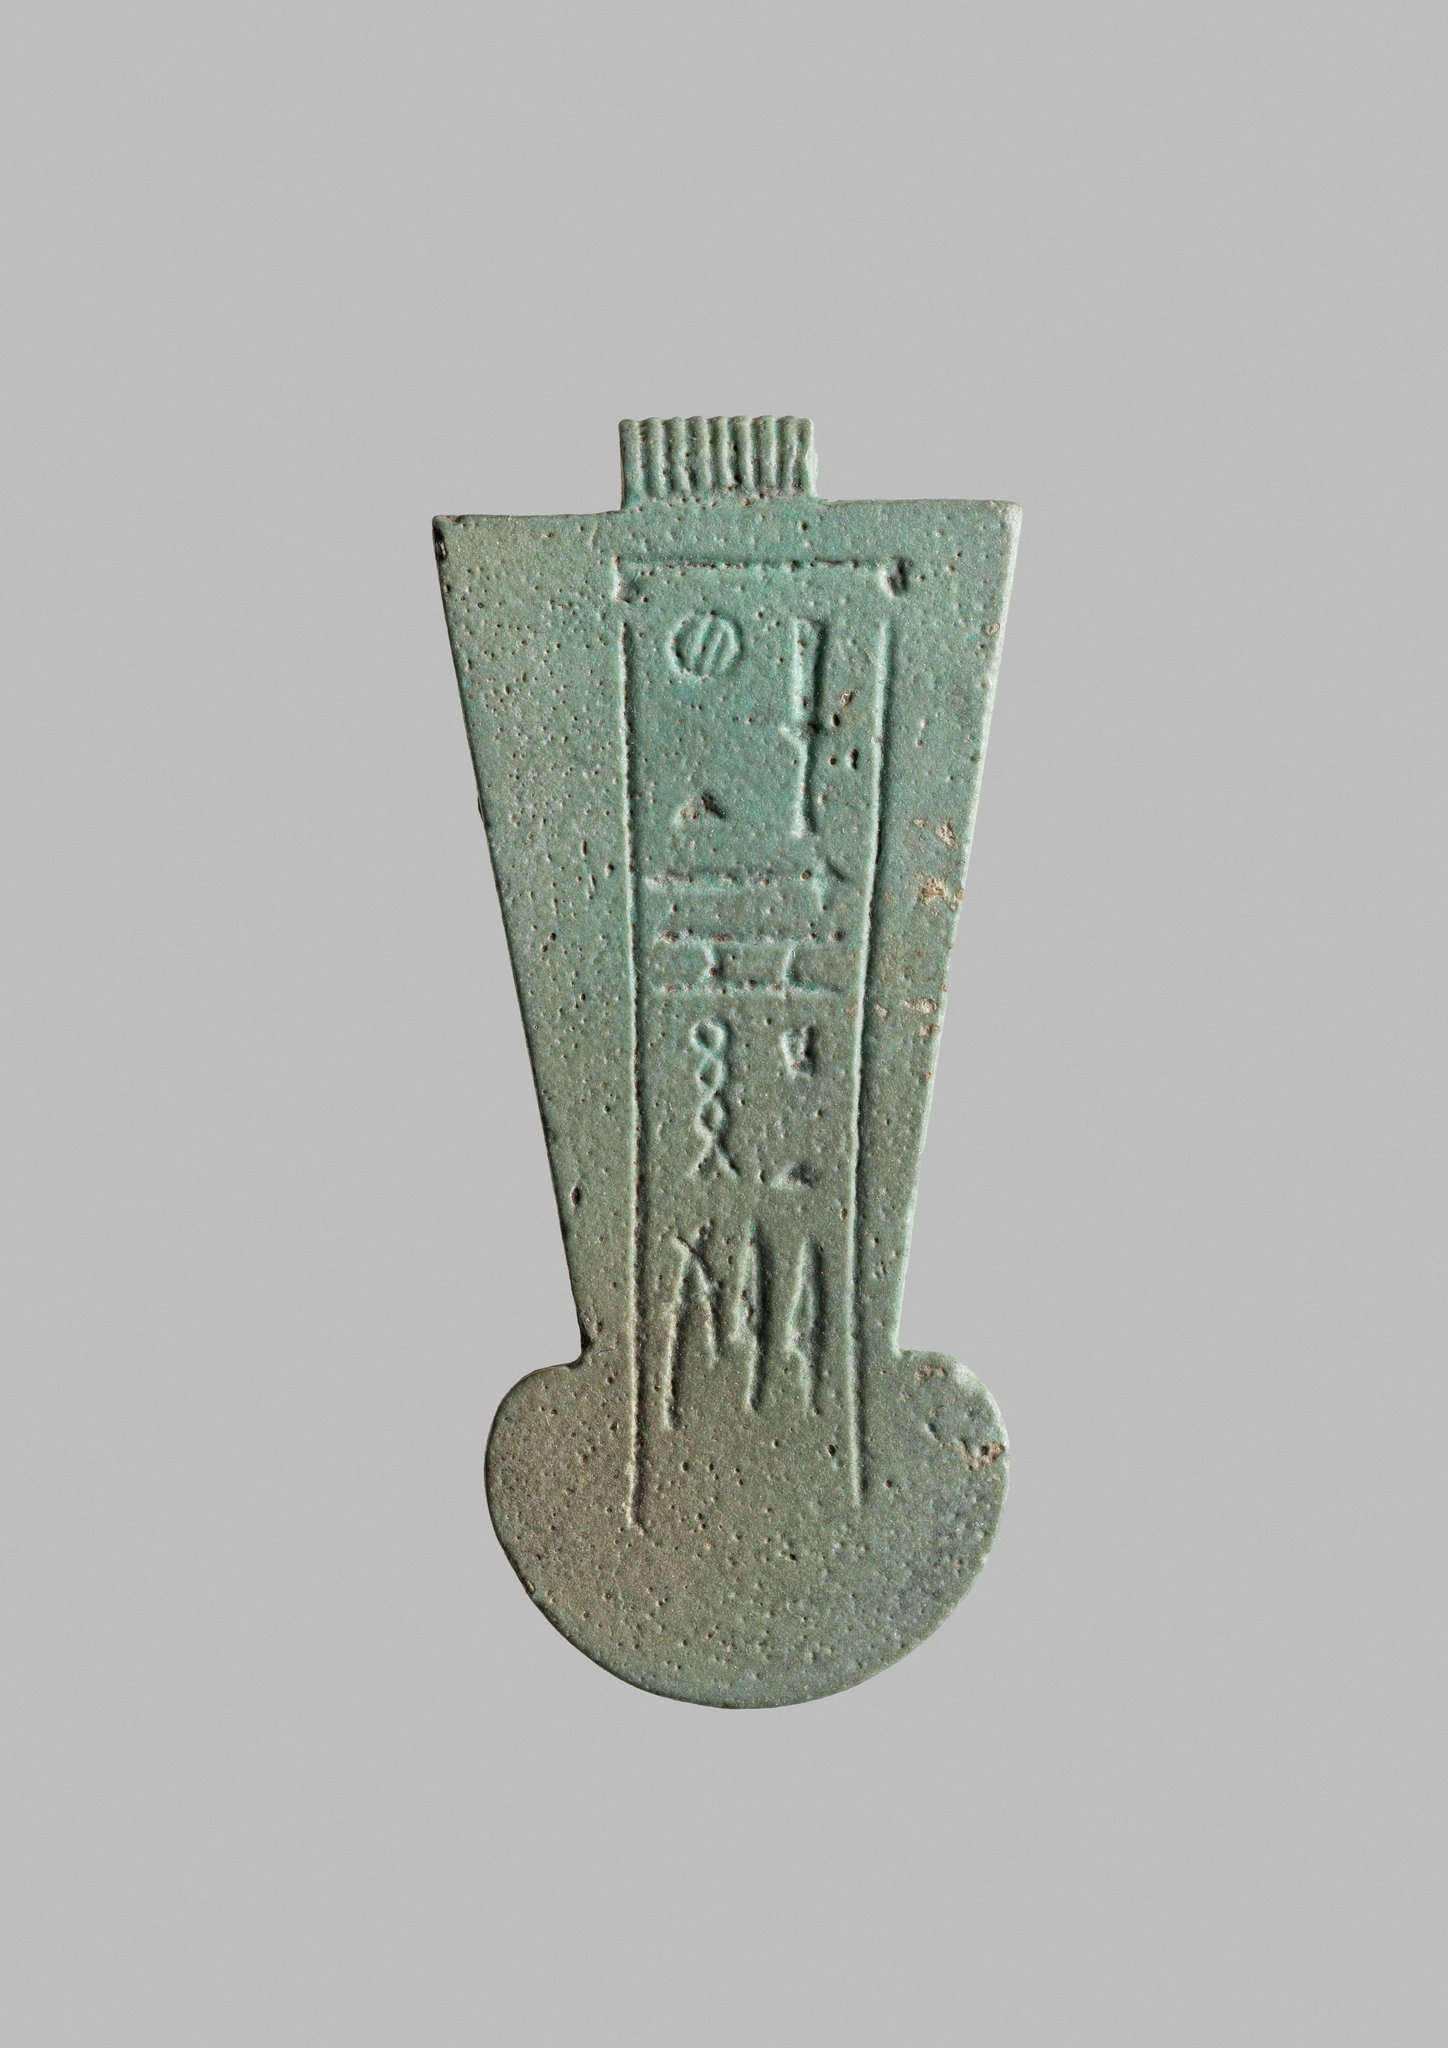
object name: menat counterpoise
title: Menat Counterpoise inscribed beloved of Sakhmet the Great, Beloved of Ptah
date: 664-525 BCE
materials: faience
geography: egypt